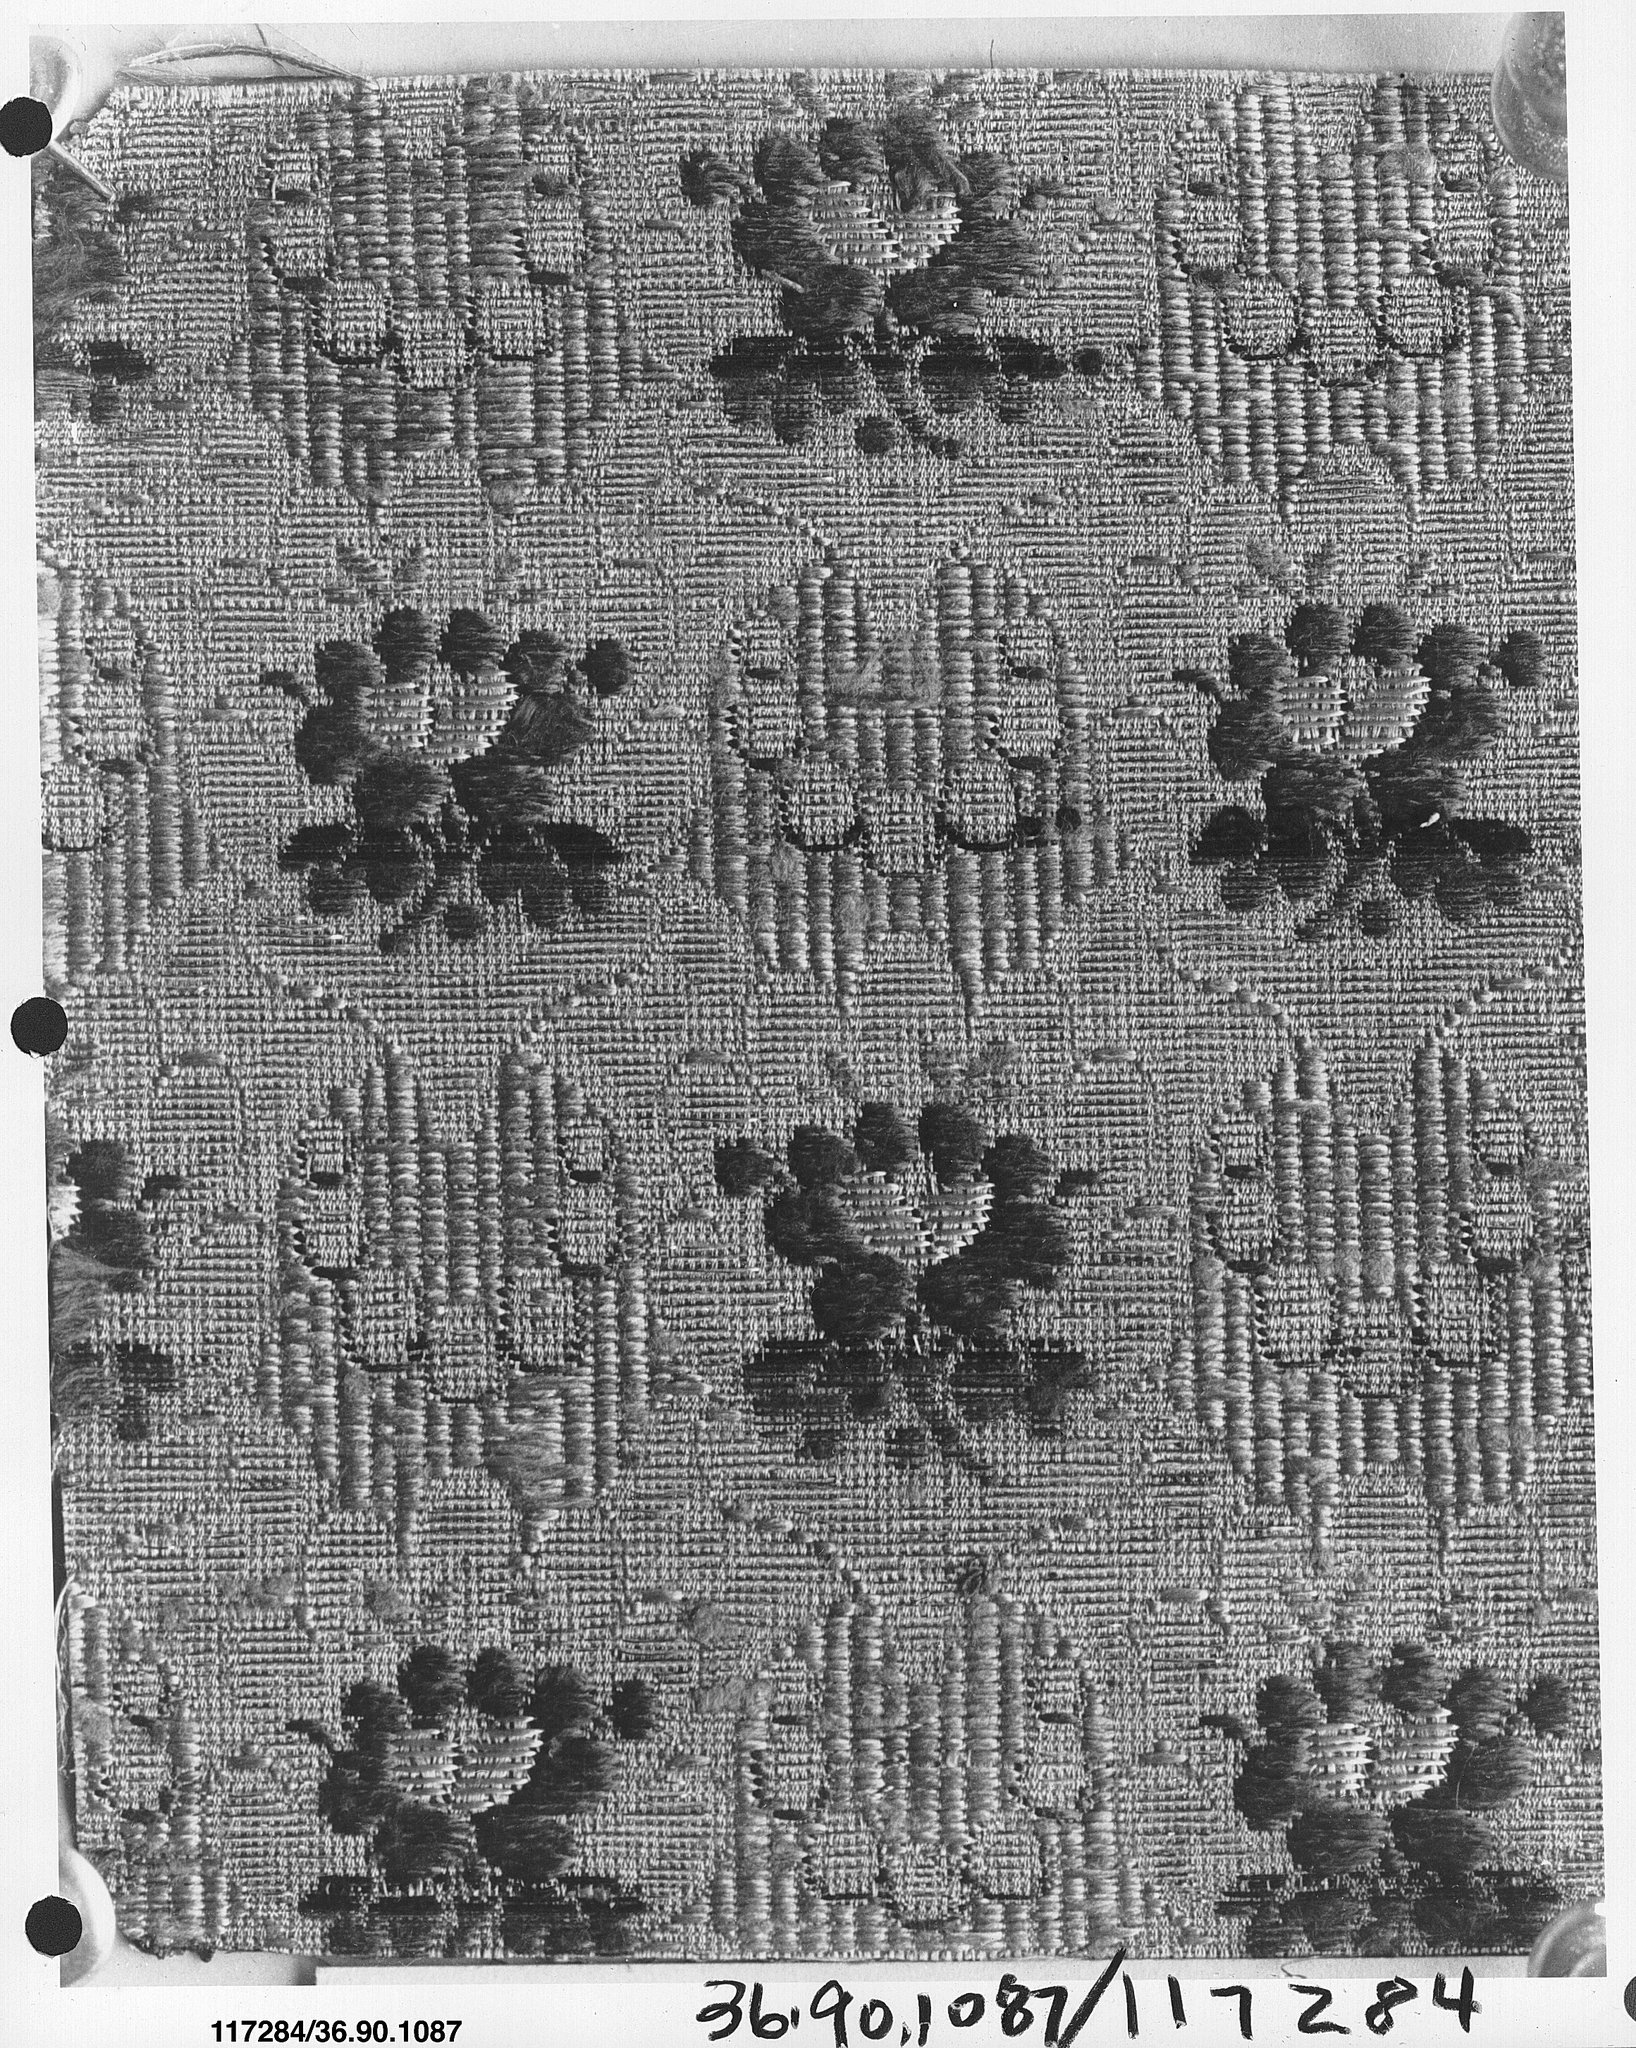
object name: piece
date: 1701-1900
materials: metal thread, silk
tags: flowers